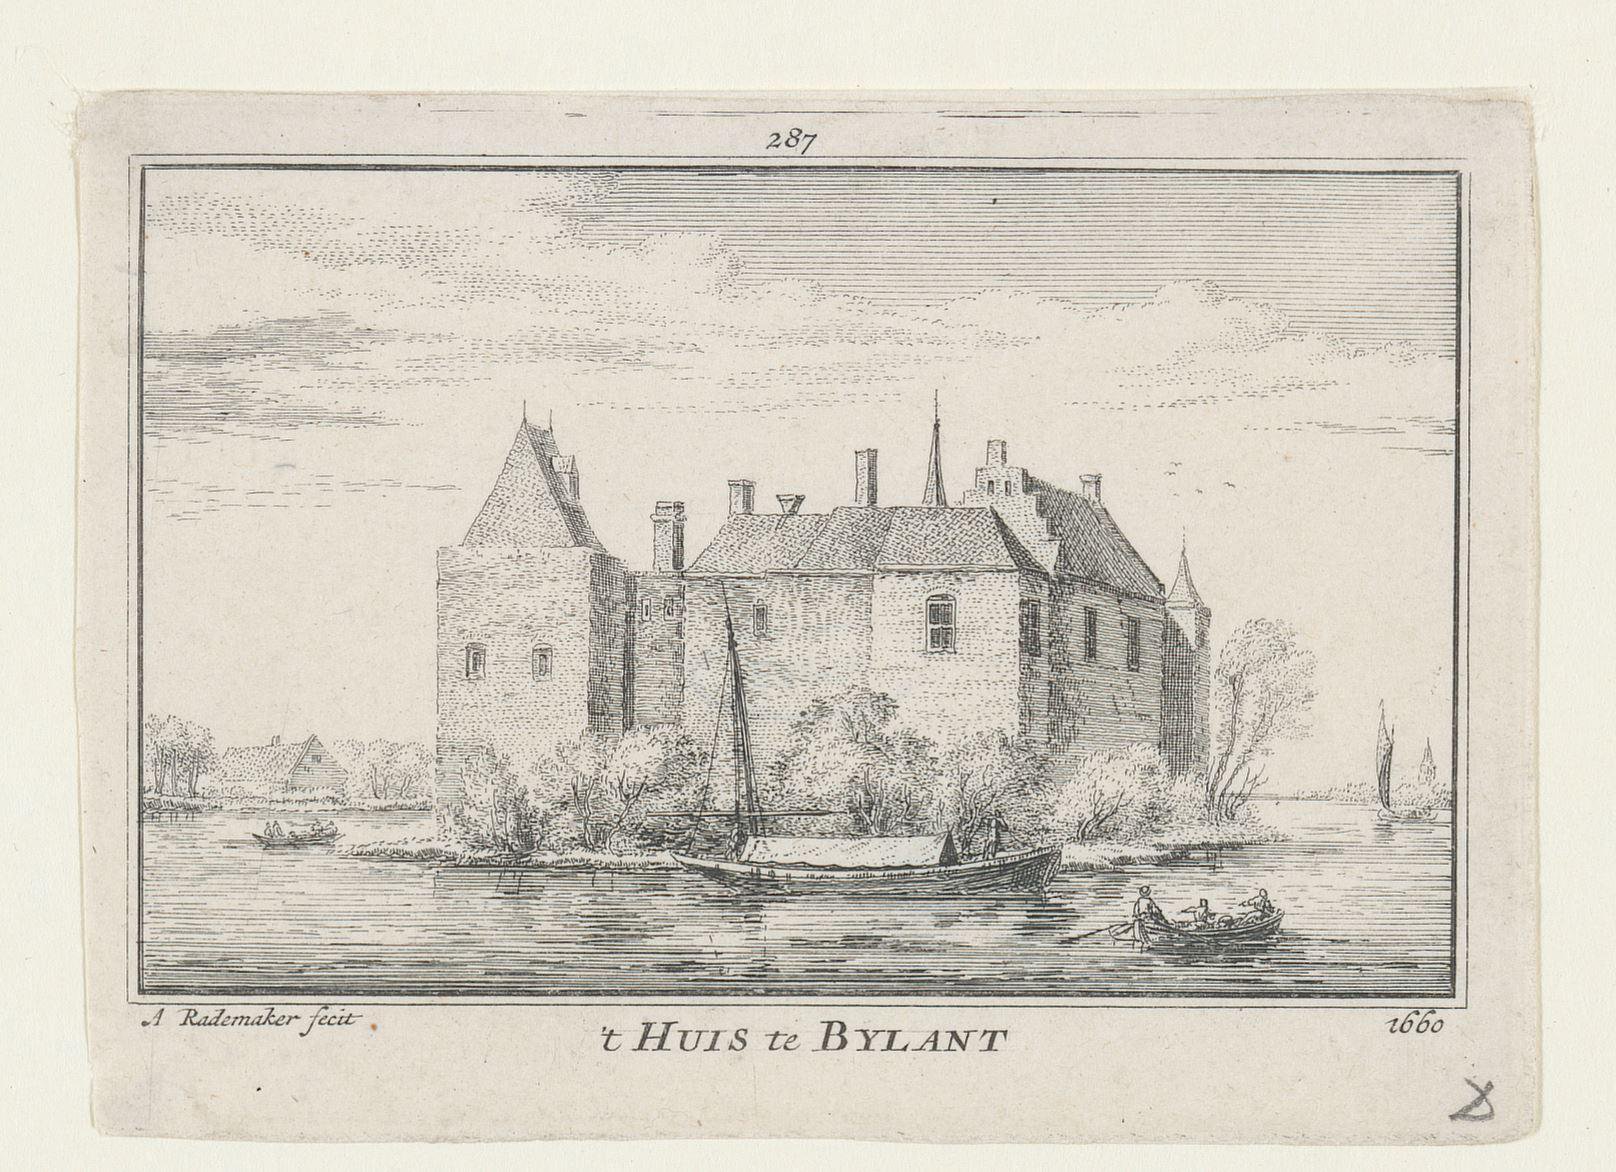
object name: book illustration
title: 't Huis te Bylant 1660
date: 1727-1733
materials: paper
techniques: etching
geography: amsterdam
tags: castle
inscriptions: collector's mark: Lugt 2228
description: Prent gebruikt in: Kabinet van Nederlandsche en Kleefsche outheden en (...) voorname stads- en landgebouwen. Amsterdam: Willem Barents en Antoni Schoonenburg,1727-1733, ill. 287.